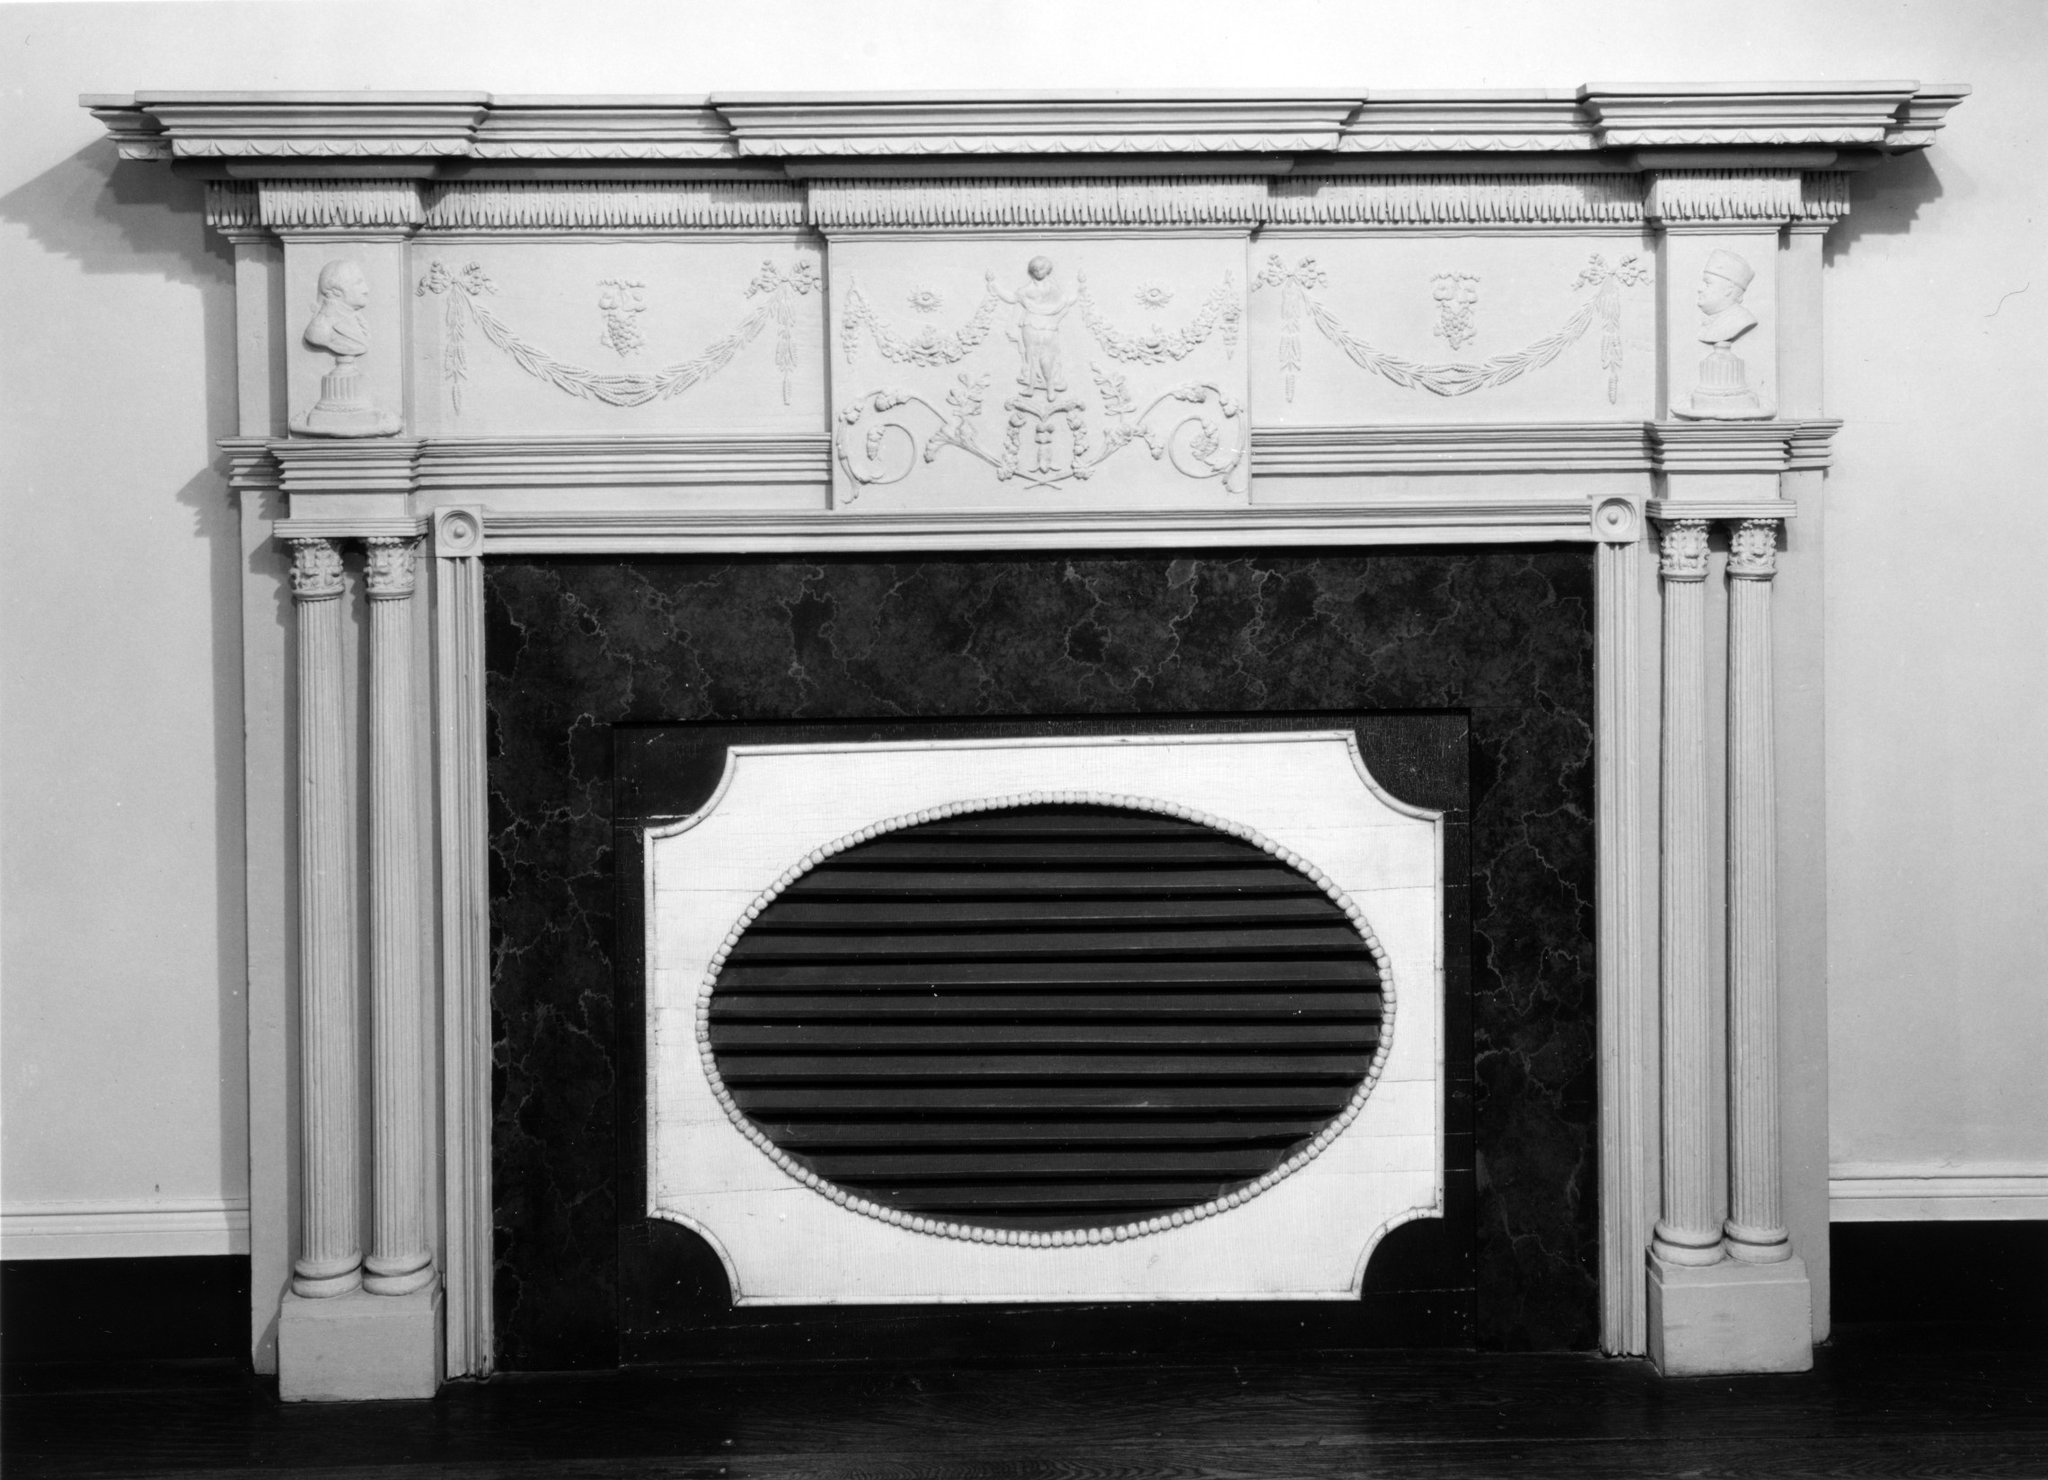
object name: fireboard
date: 1800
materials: wood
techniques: painting